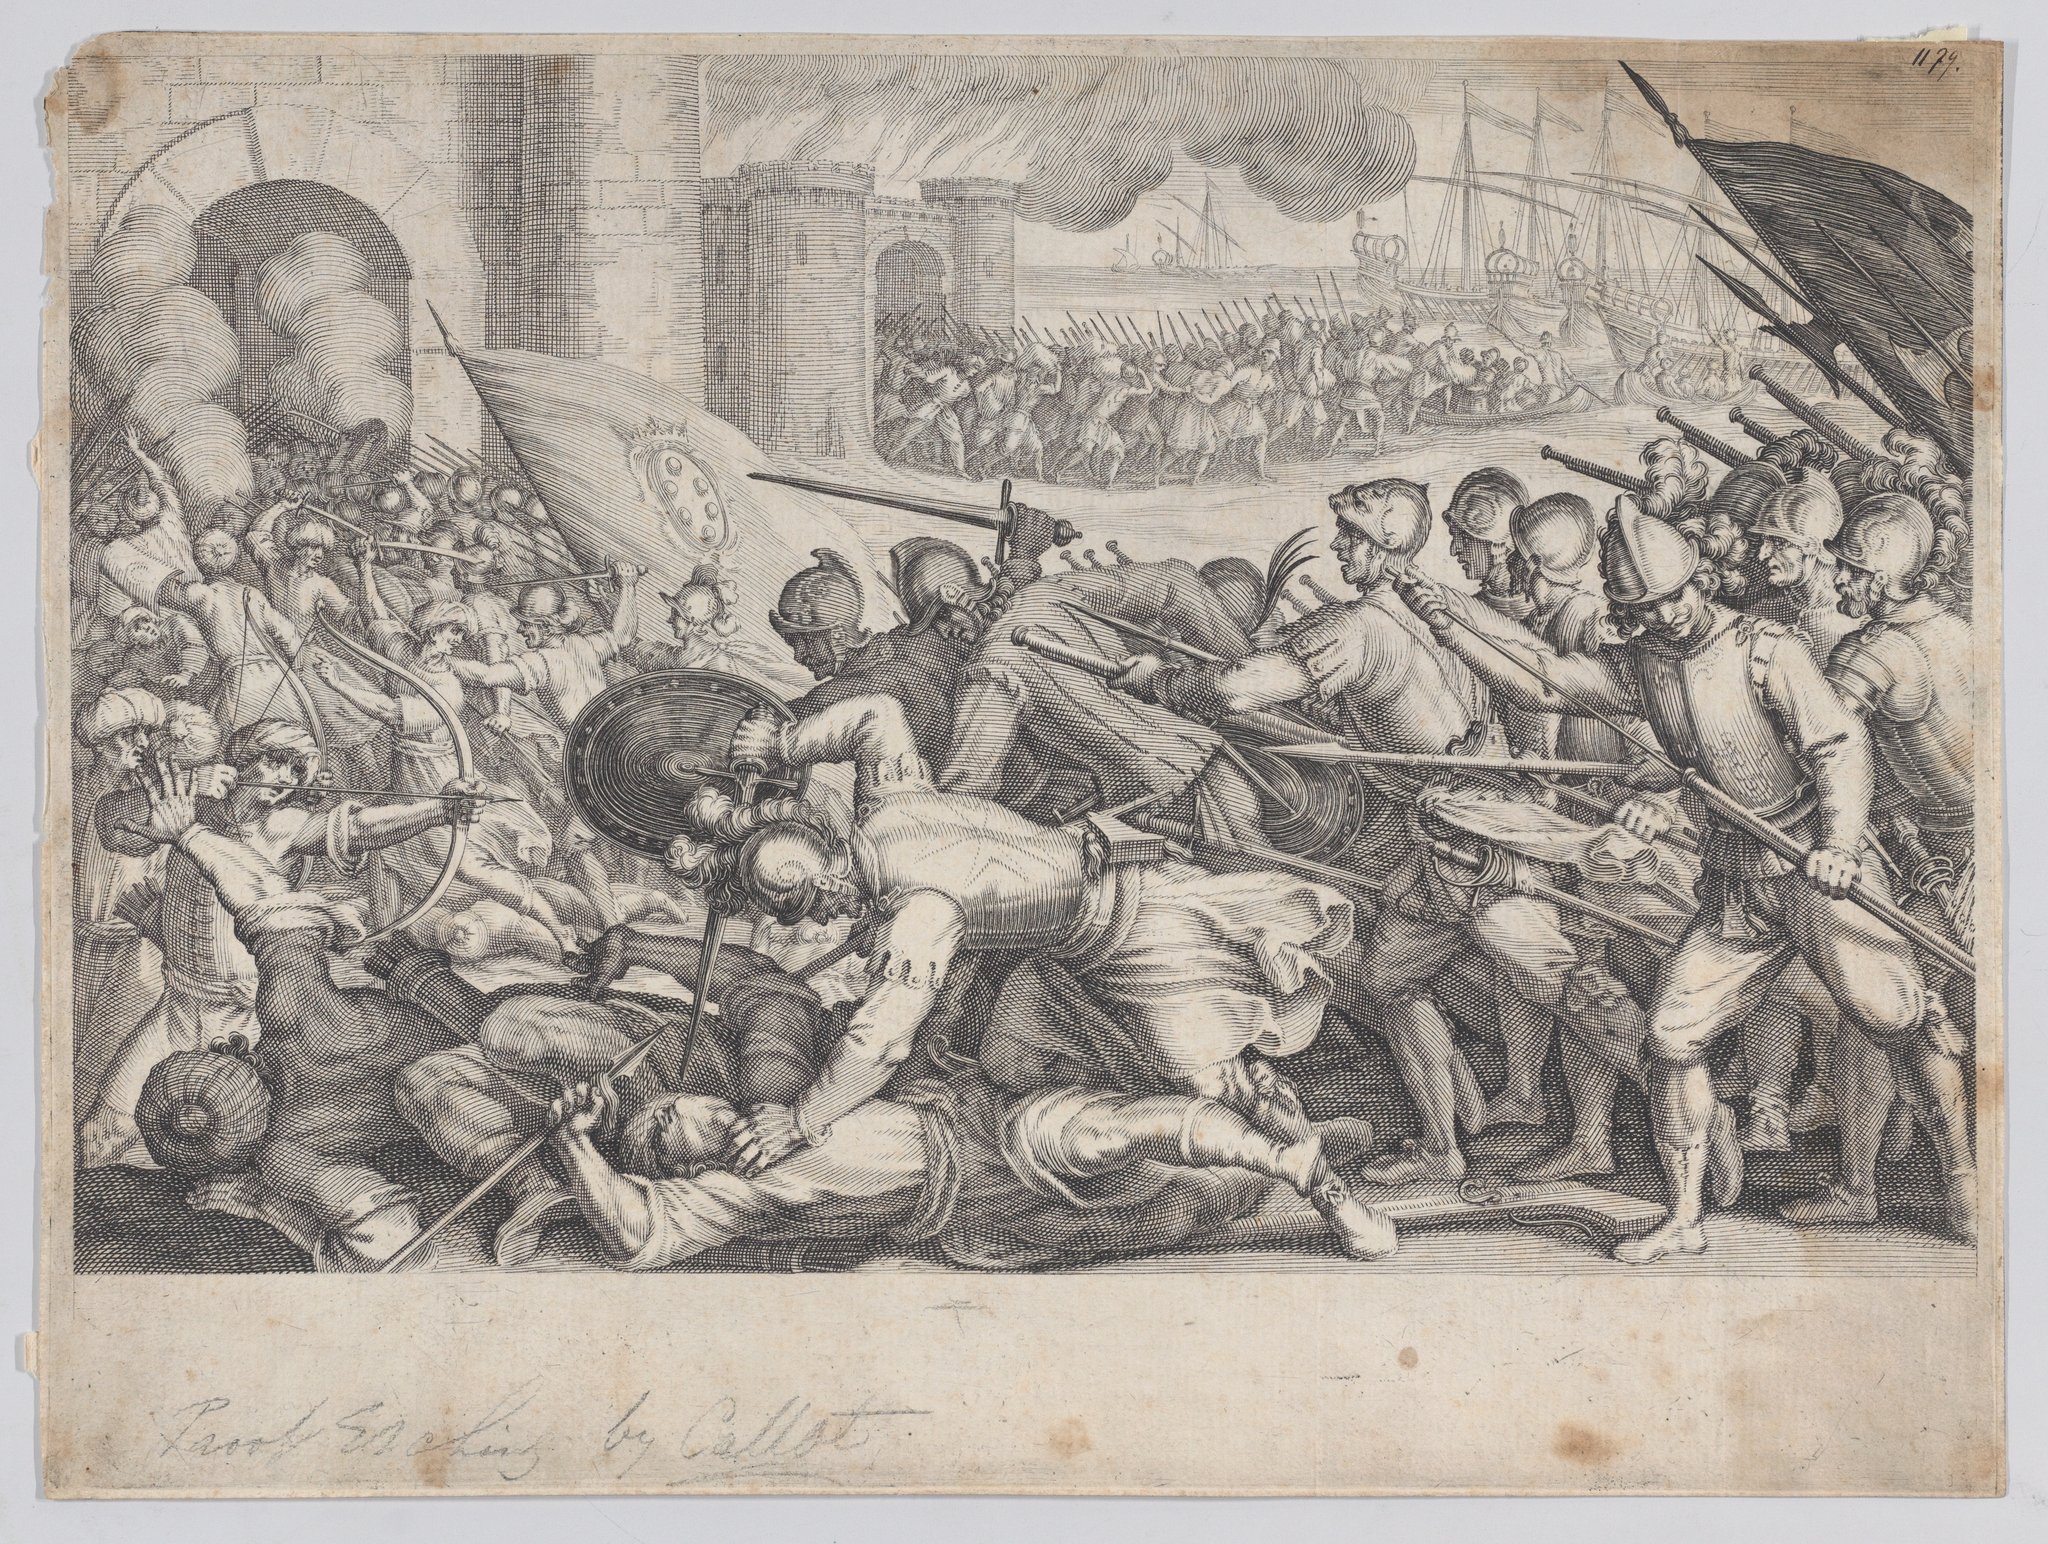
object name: print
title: Les Troupes Forcent la Porte d'une Ville (The Troops Force Their Way Through the Gate of a City), from "La Vie de Ferdinand Ier de Médicis série appelée aussi Les Batailles des Médicis" (The Life of Ferdinand I de'Medici also called The Medici Battles)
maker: jacques callot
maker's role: artist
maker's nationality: french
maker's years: 1592-1635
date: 1614-1620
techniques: engraving